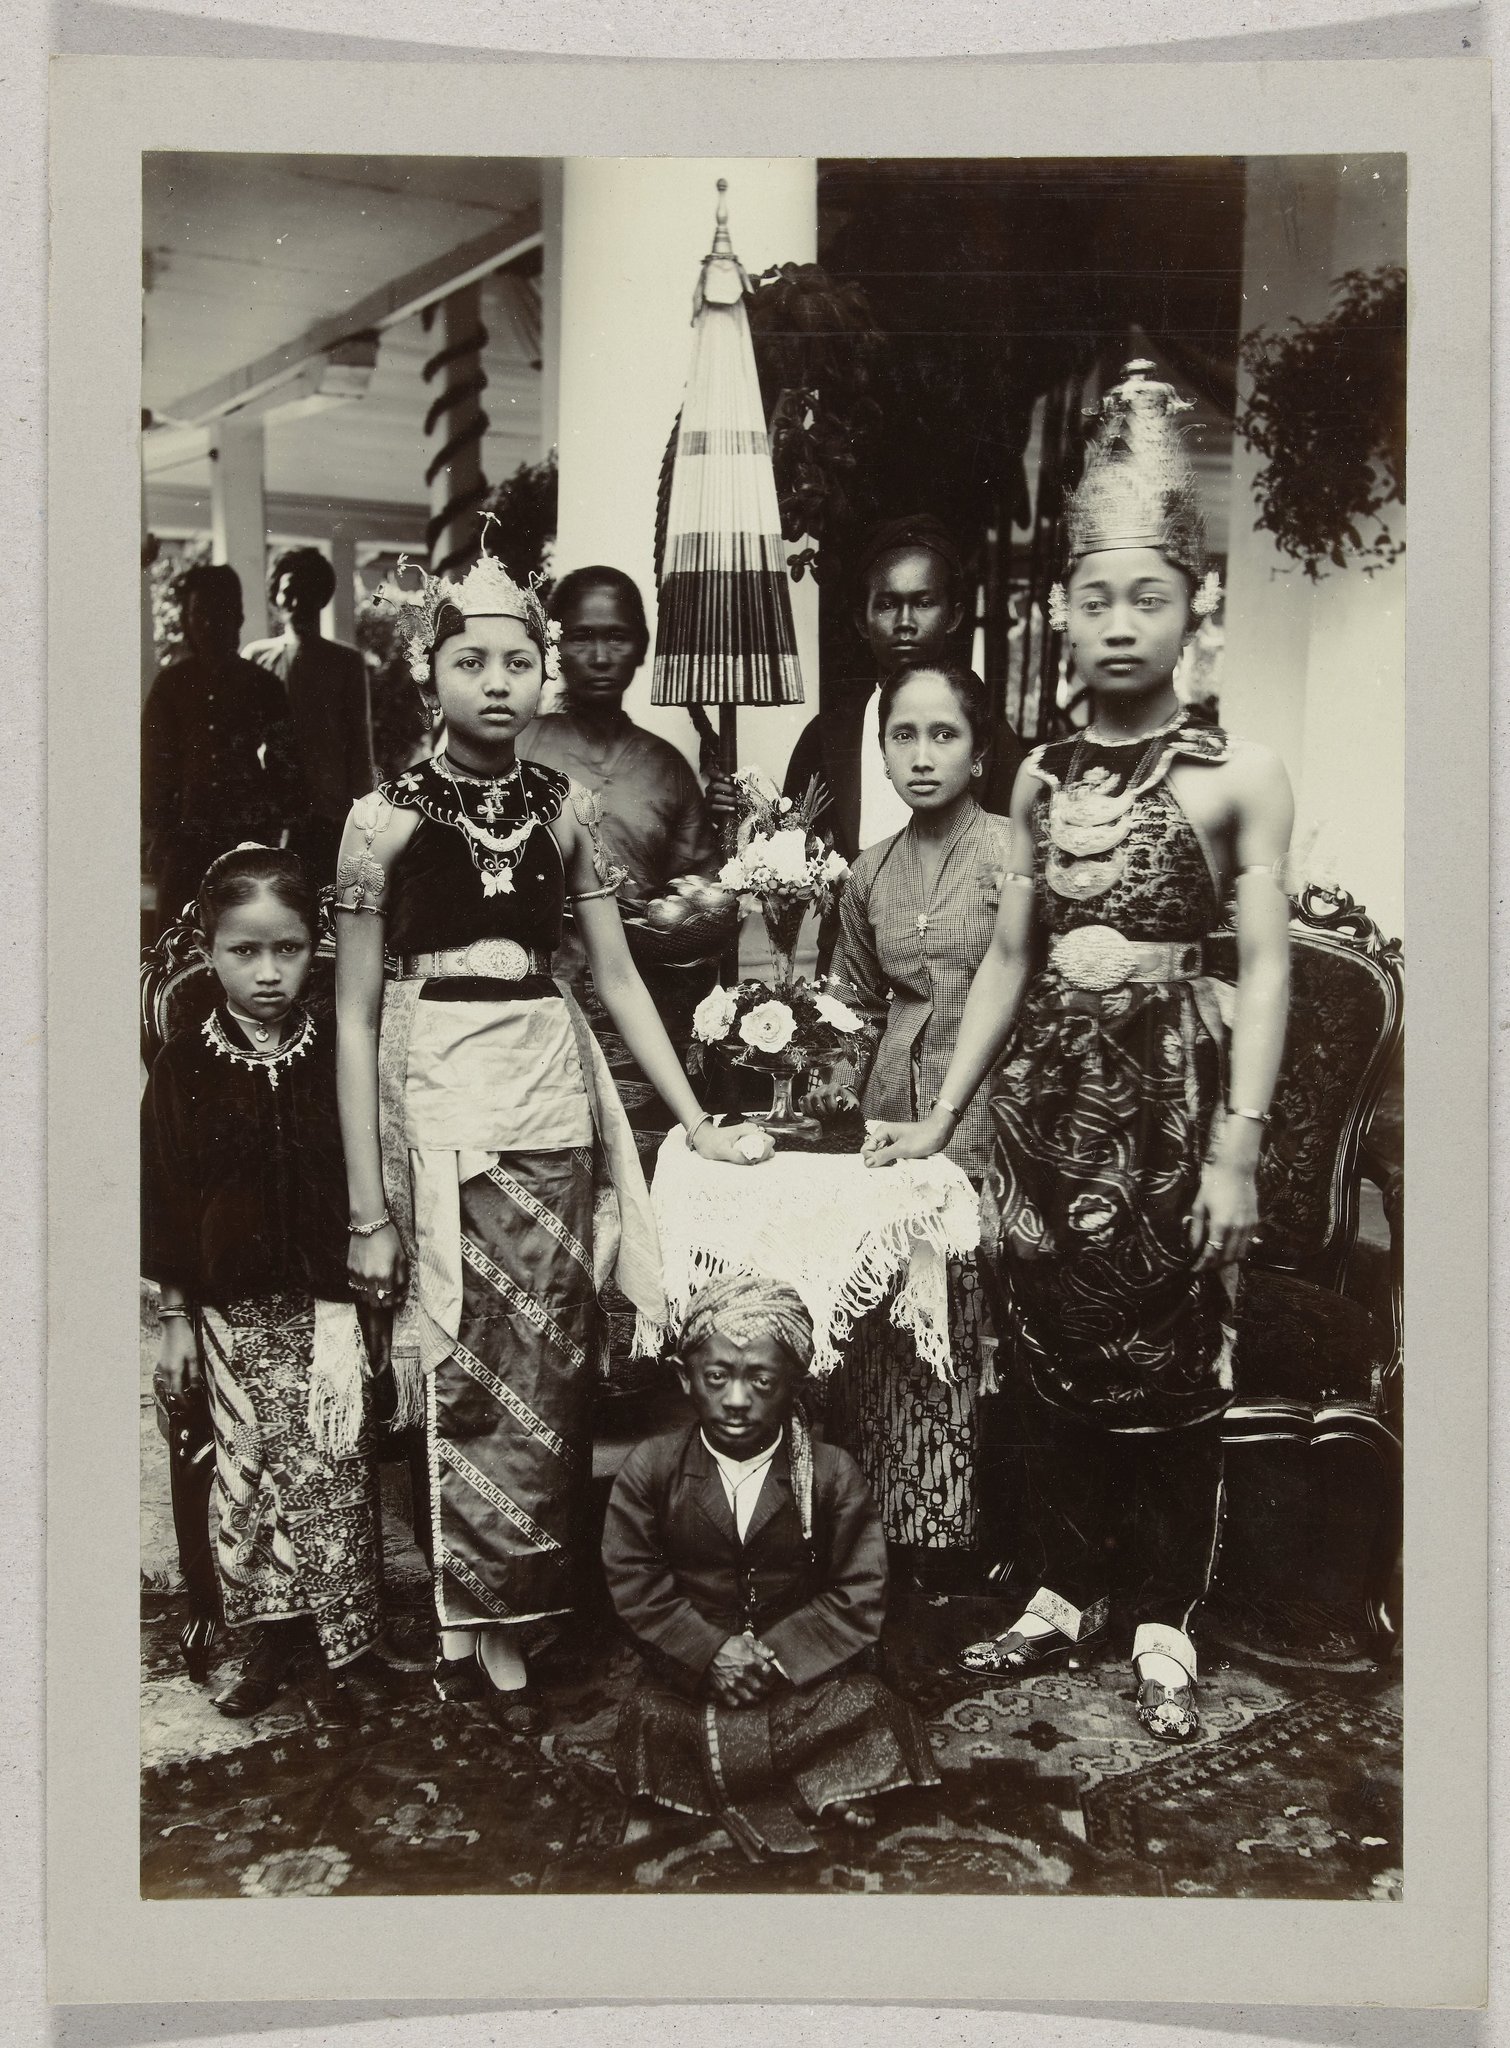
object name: photograph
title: Groepsportret met een dwerg, in feestelijke kledij in Nederlands-Indië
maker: Anonymous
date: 1895-1915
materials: cardboard, paper, photographic support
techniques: gelatin silver print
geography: dutch east indies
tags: indonesia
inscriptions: number: ‘37’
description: Groepsportret met een kleine mens, in feestelijke kledij, Nederlands-Indië.